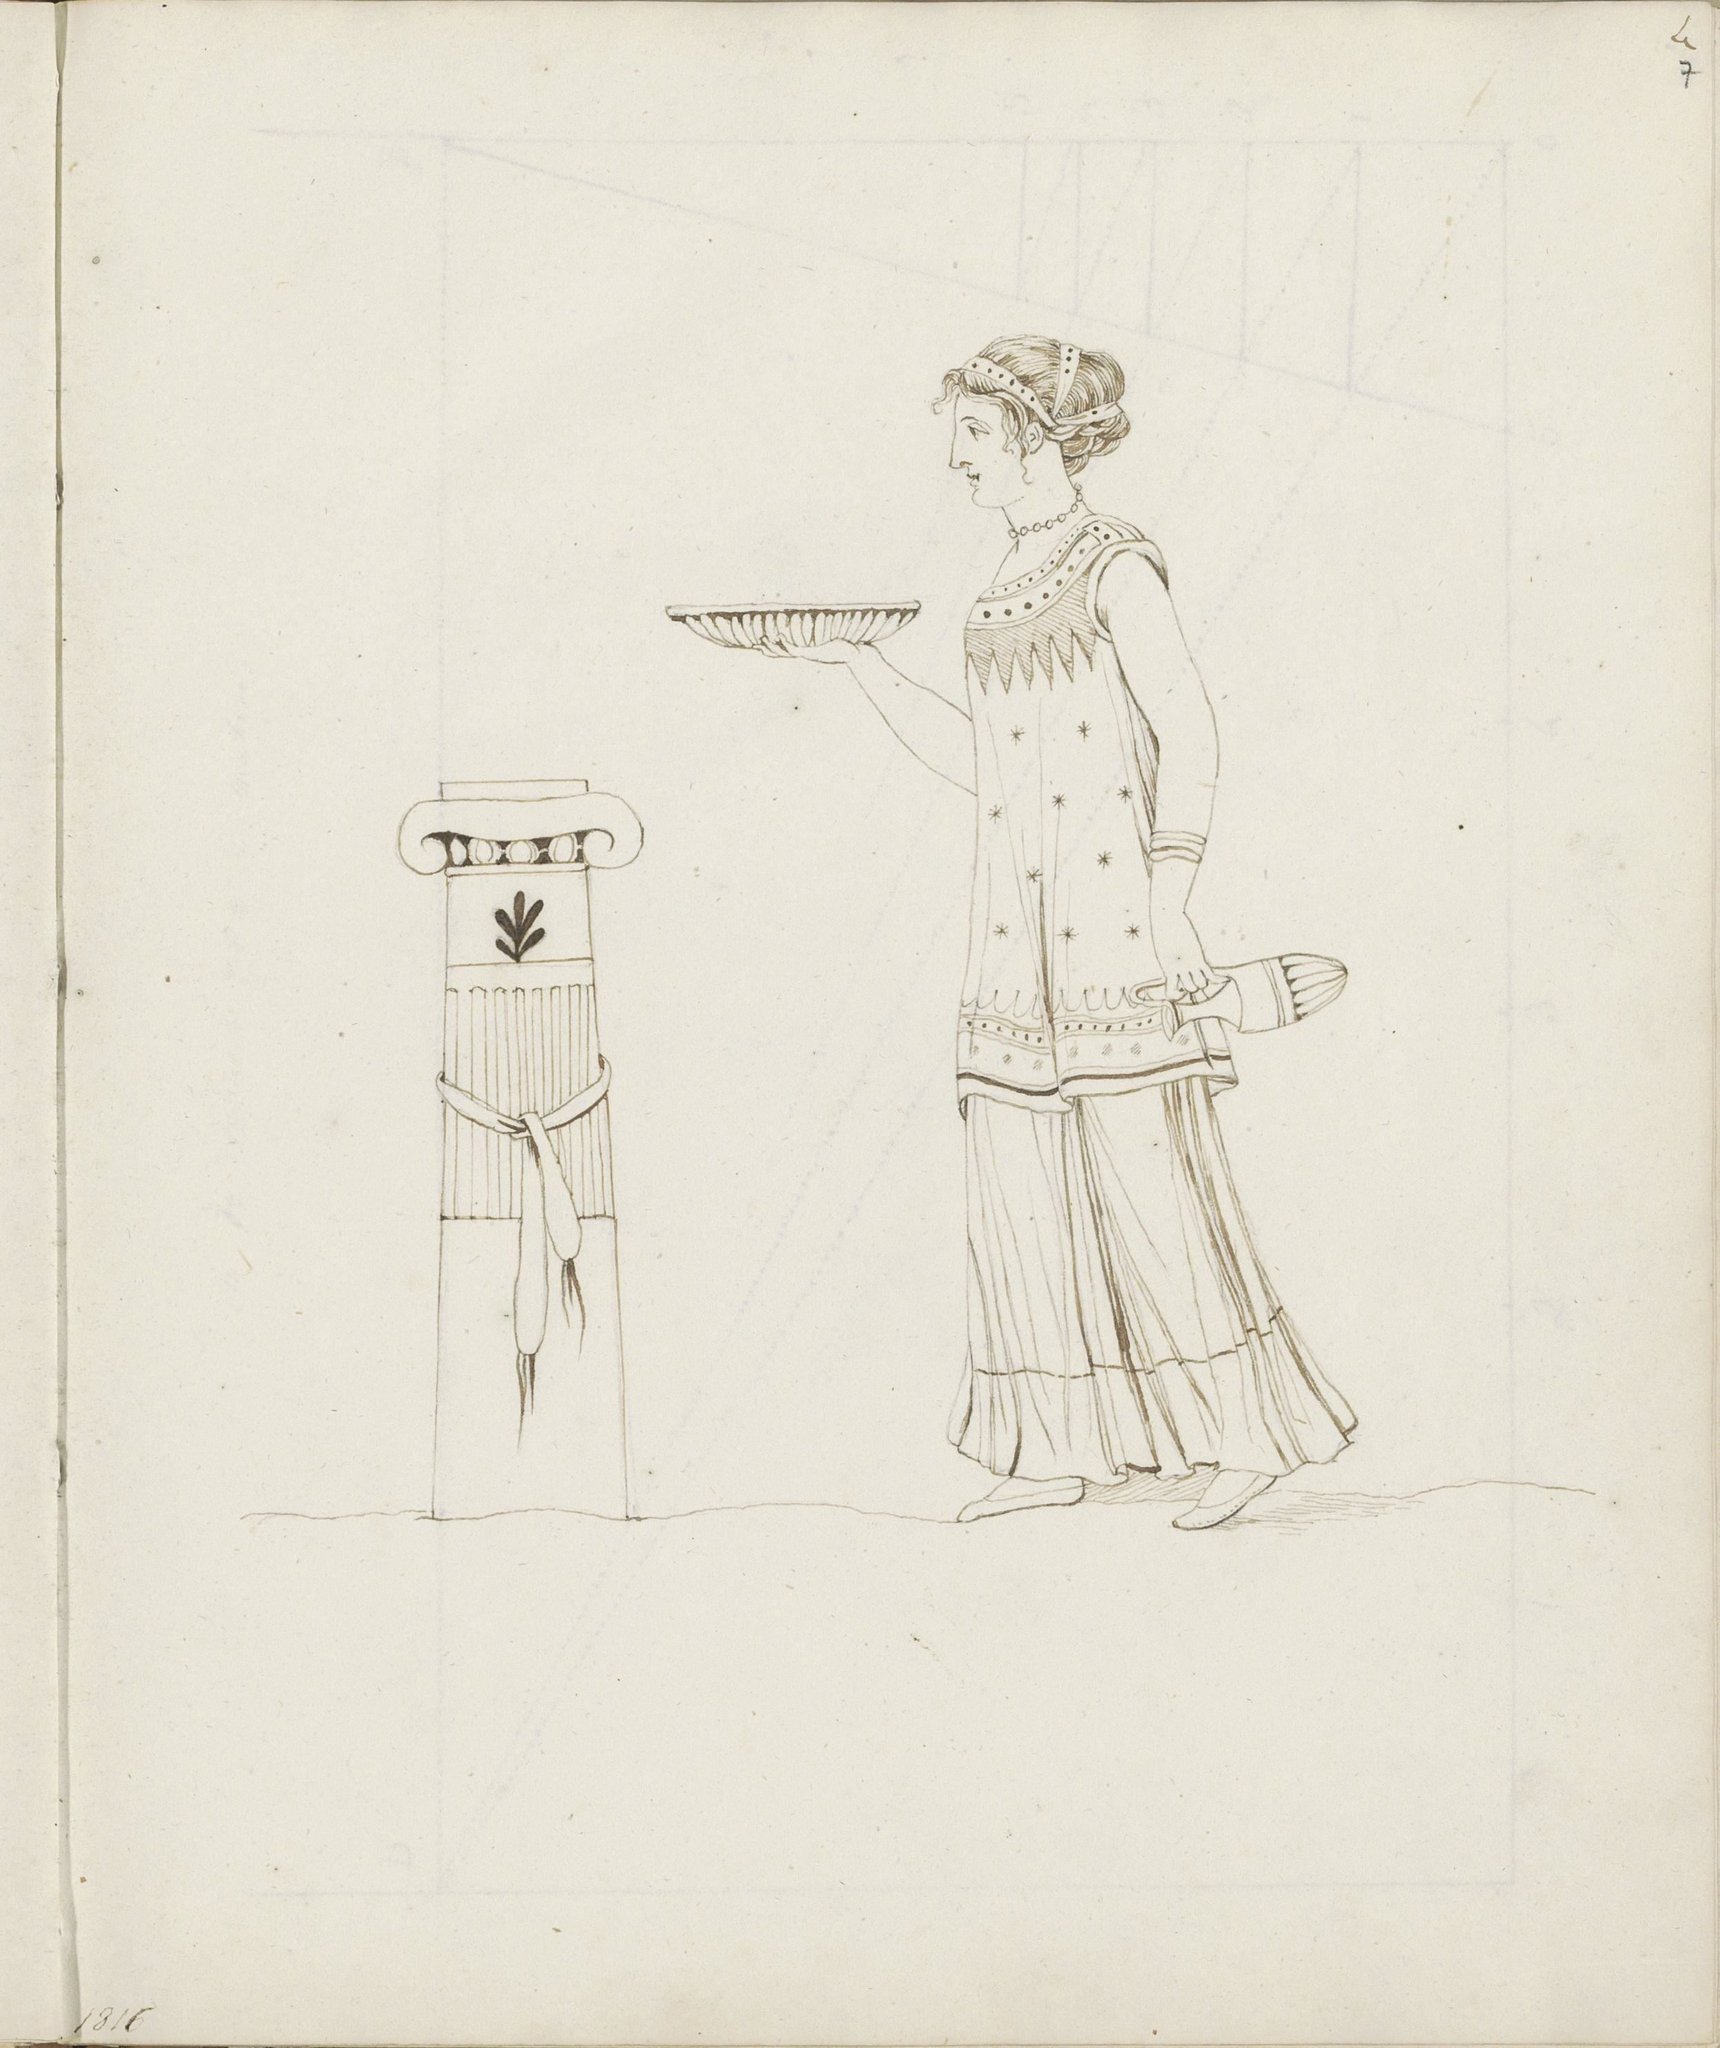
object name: sketchbook leaf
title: Vrouw die een offer brengt, naar klassiek voorbeeld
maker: jonkvrouw elisabeth kemper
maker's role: draughtsman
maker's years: 1799-1871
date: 1816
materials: ink, paper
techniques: pen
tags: carrying something, female persons from classical history (+ belonging to greek history), ionic order ~ architecture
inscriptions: date: ‘1816’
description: De vrouw draagt een tuniek en parelketting en loopt met een vaas en schaal richting een altaar in de vorm van een sokkel met een Ionisch kapiteel. Blad 7 recto uit een schetsboek met 94 bladen.